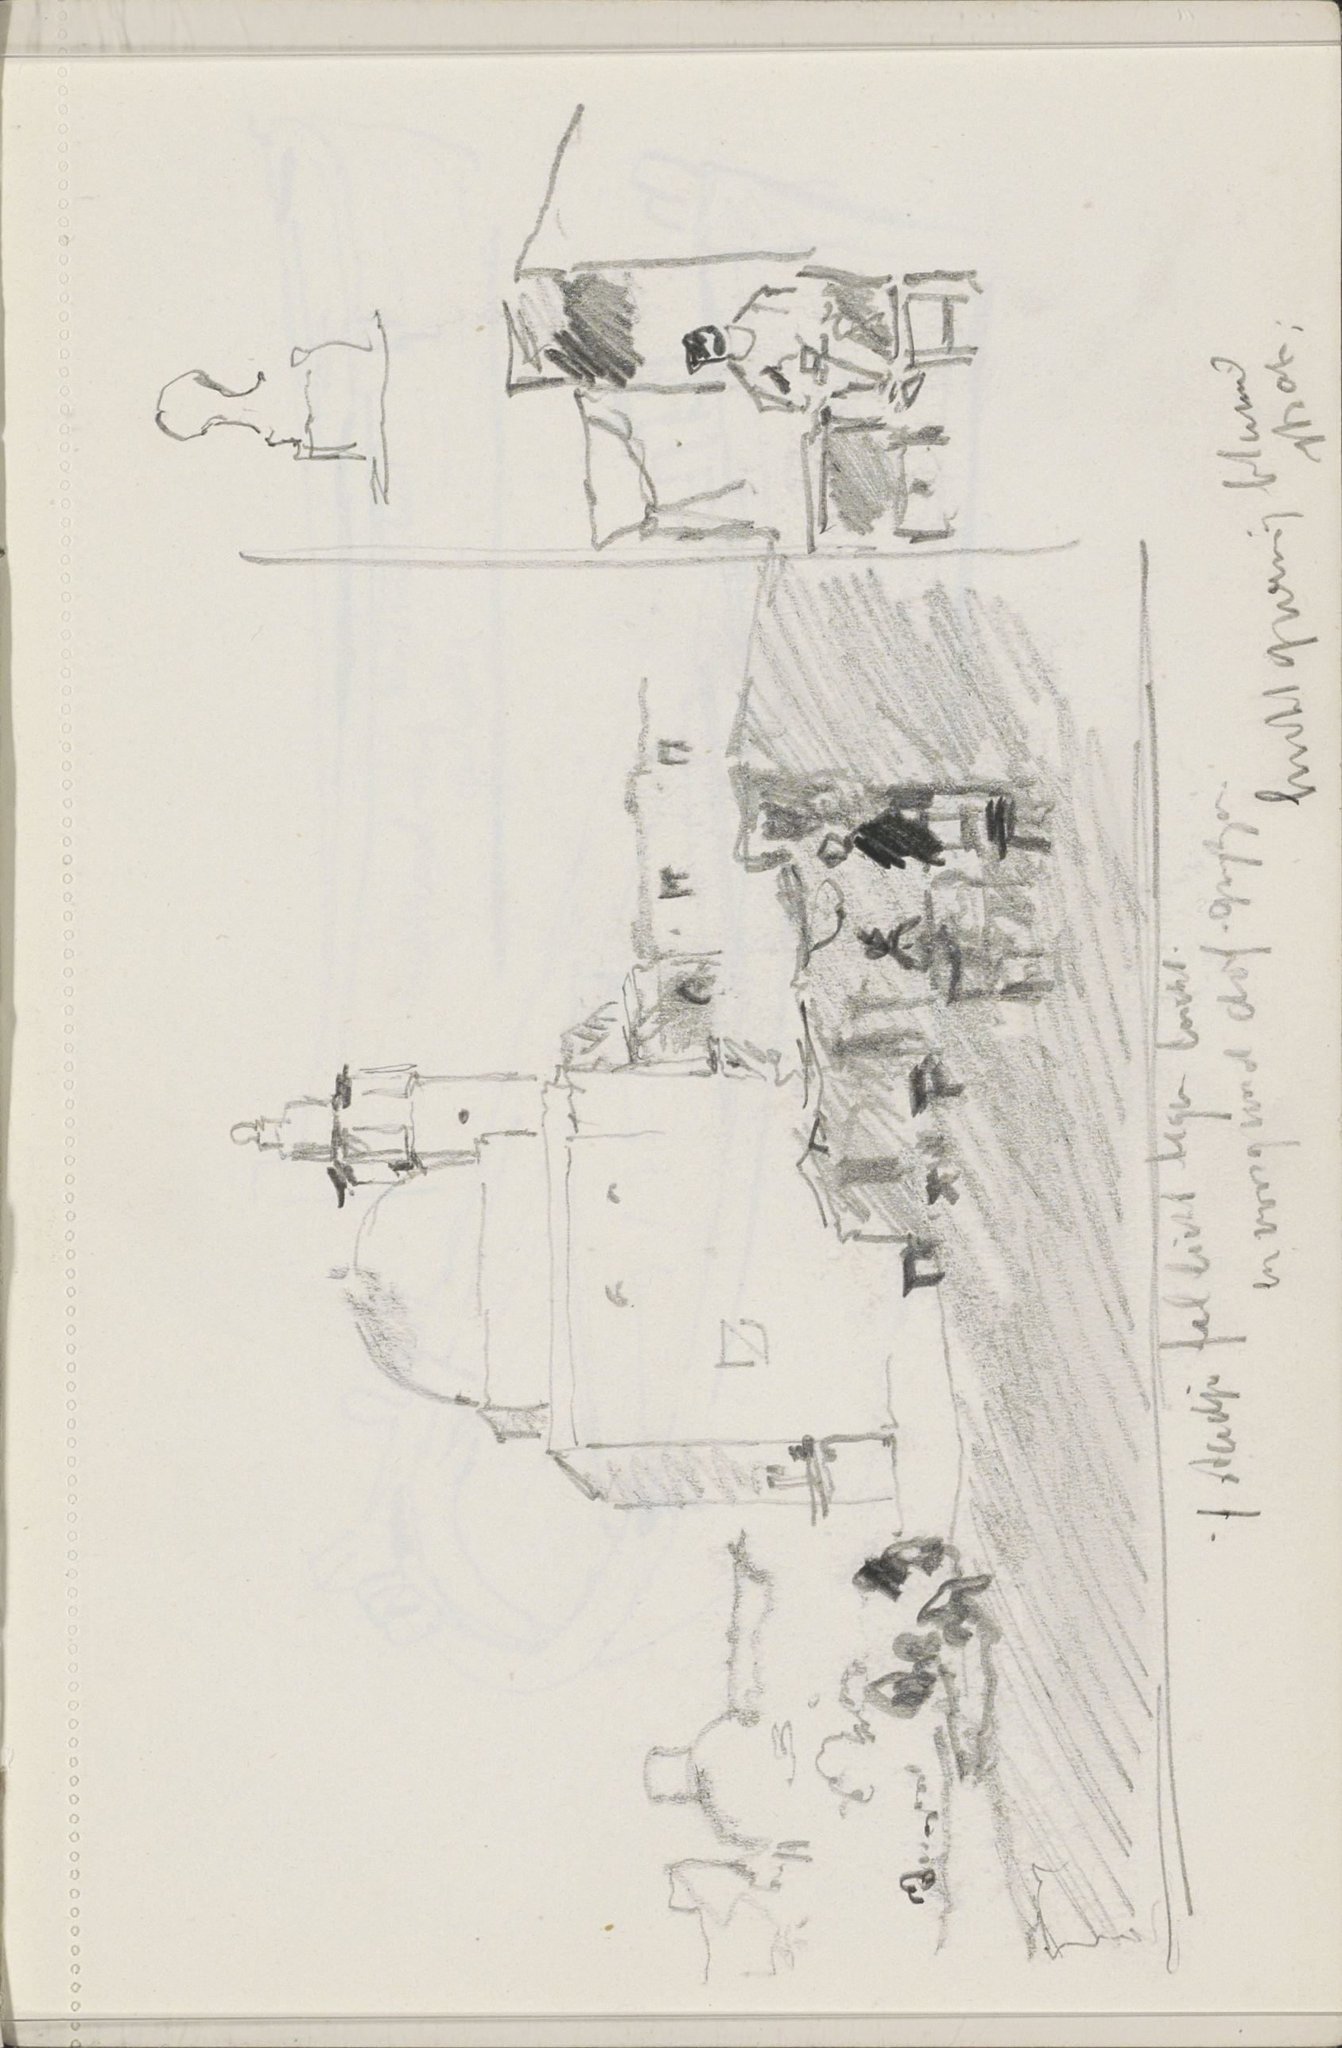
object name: sketchbook leaf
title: Gezicht op een stad met een moskee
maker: cornelis vreedenburgh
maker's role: draughtsman, print maker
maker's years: 1880-1946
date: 1936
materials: paper, pencil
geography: north africa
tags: prospect of village, silhouette of village, temple, shrine ~ islam, mohammedanism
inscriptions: kleurnotitie, handgeschreven in potlood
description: Tevens een studie van een man zittend bij een tafel. Blad 52 recto uit een schetsboek met 73 bladen.